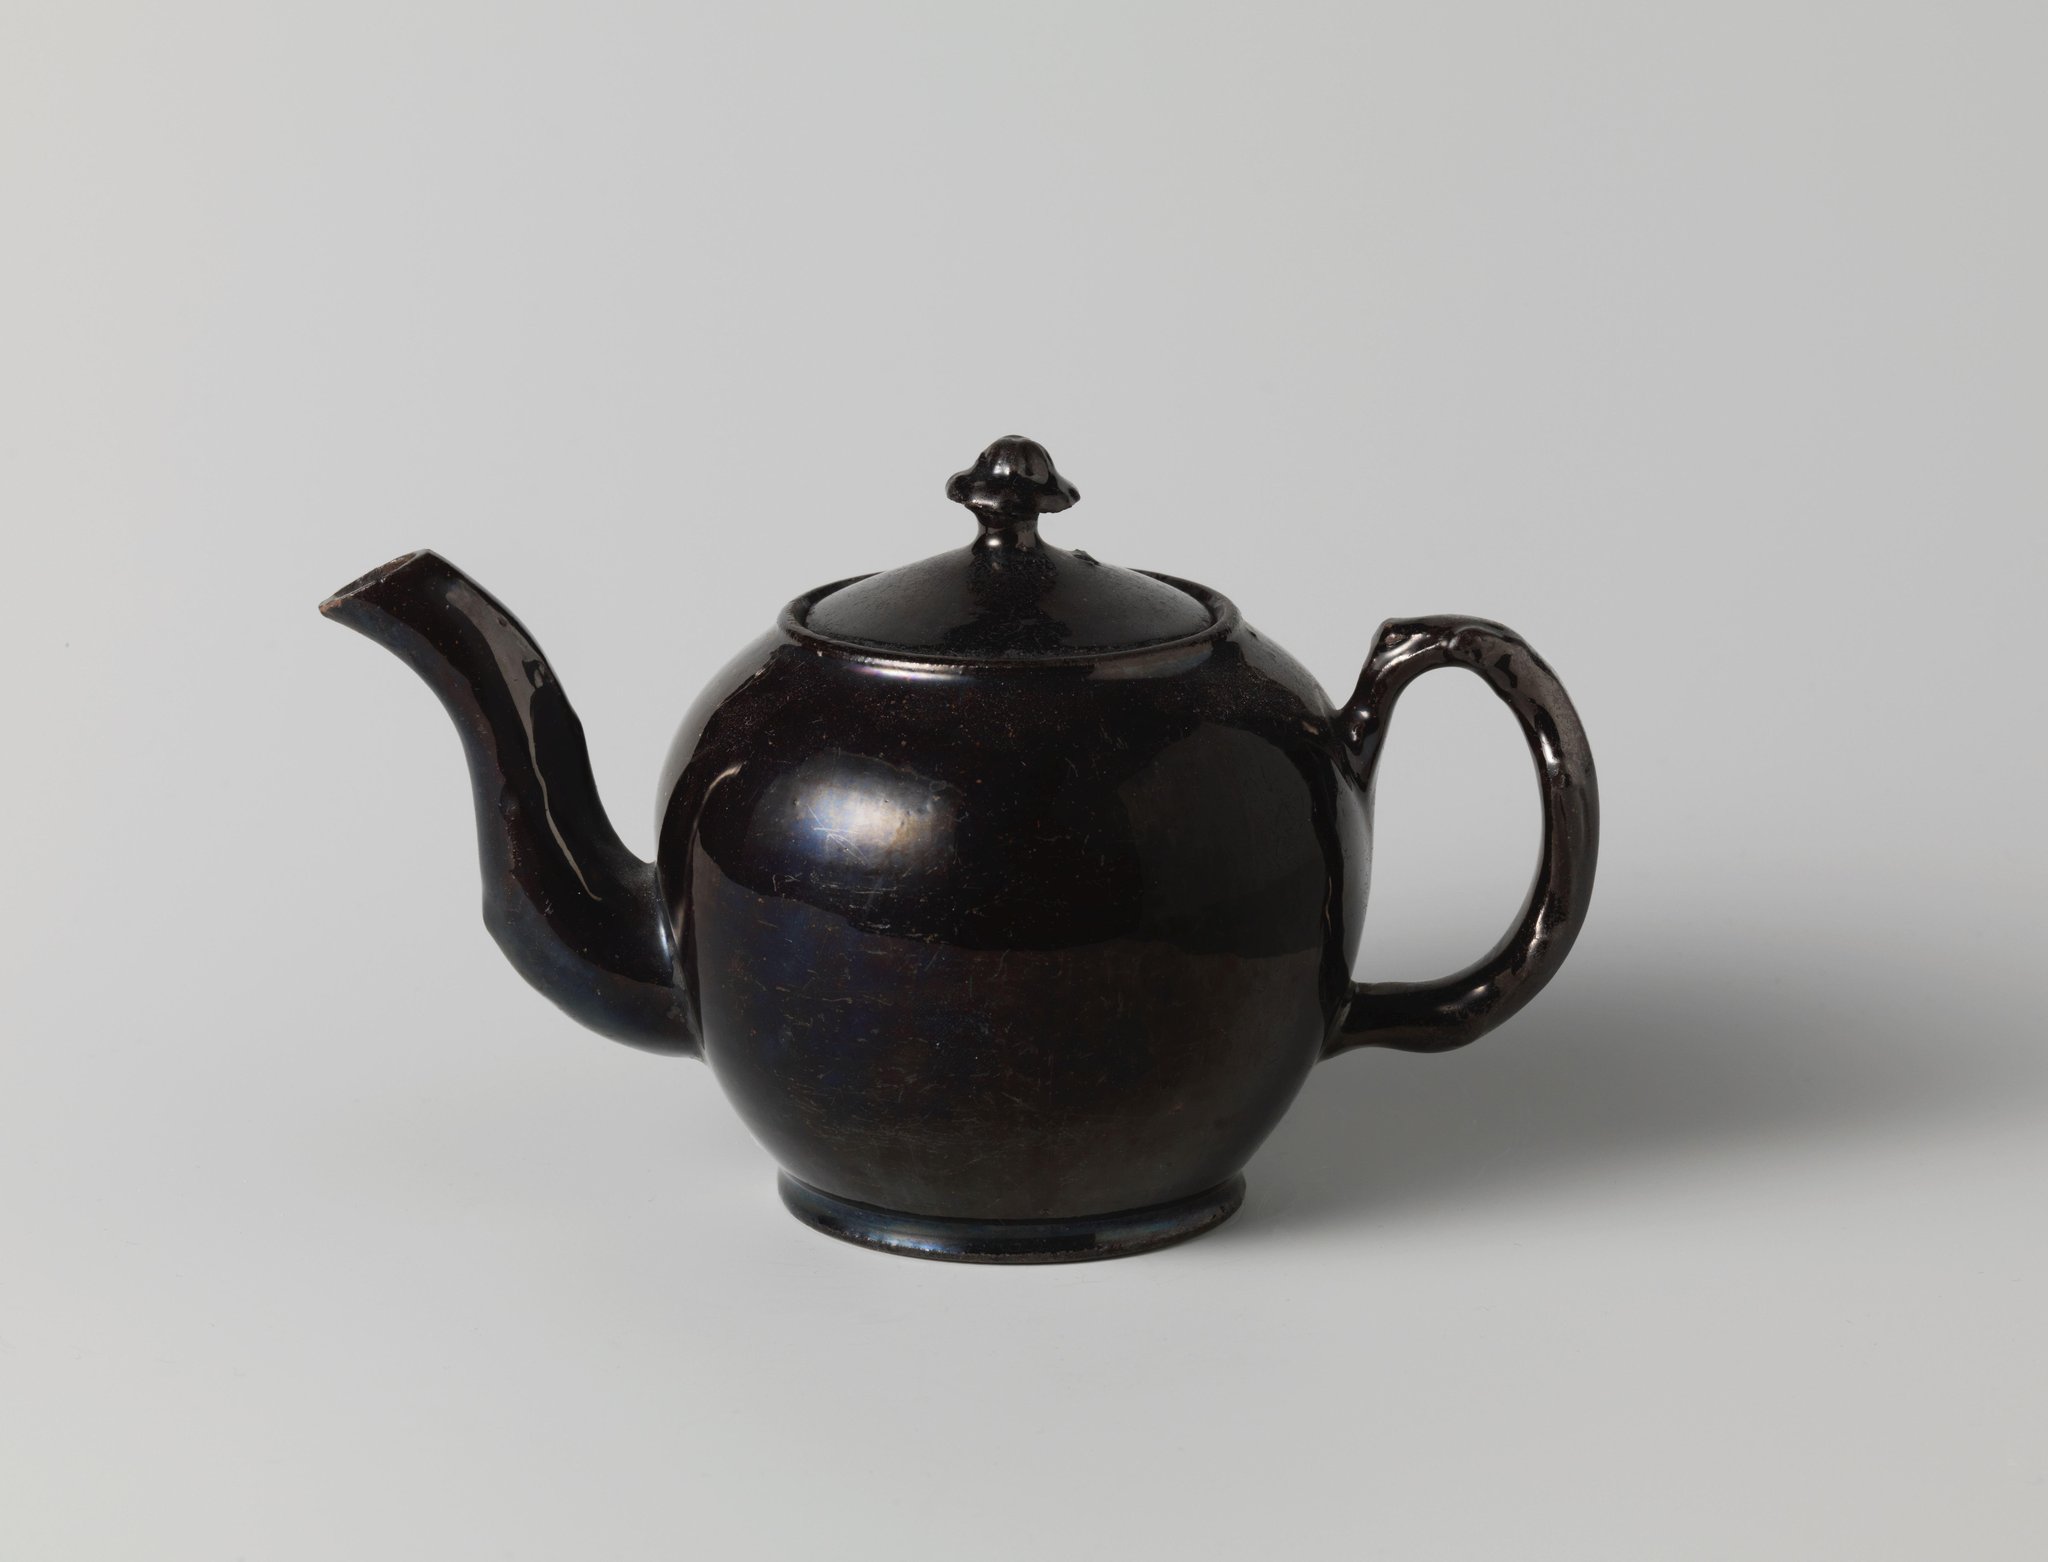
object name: pot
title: Theepot van aardewerk met zwartdekkende glazuur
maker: Anonymous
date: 1740-1770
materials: earthenware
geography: jackfield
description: Bolvormige theepot van aardewerk met zwartdekkende glazuur. De pot heeft een C-vormig oor en een S-vormige tuit.